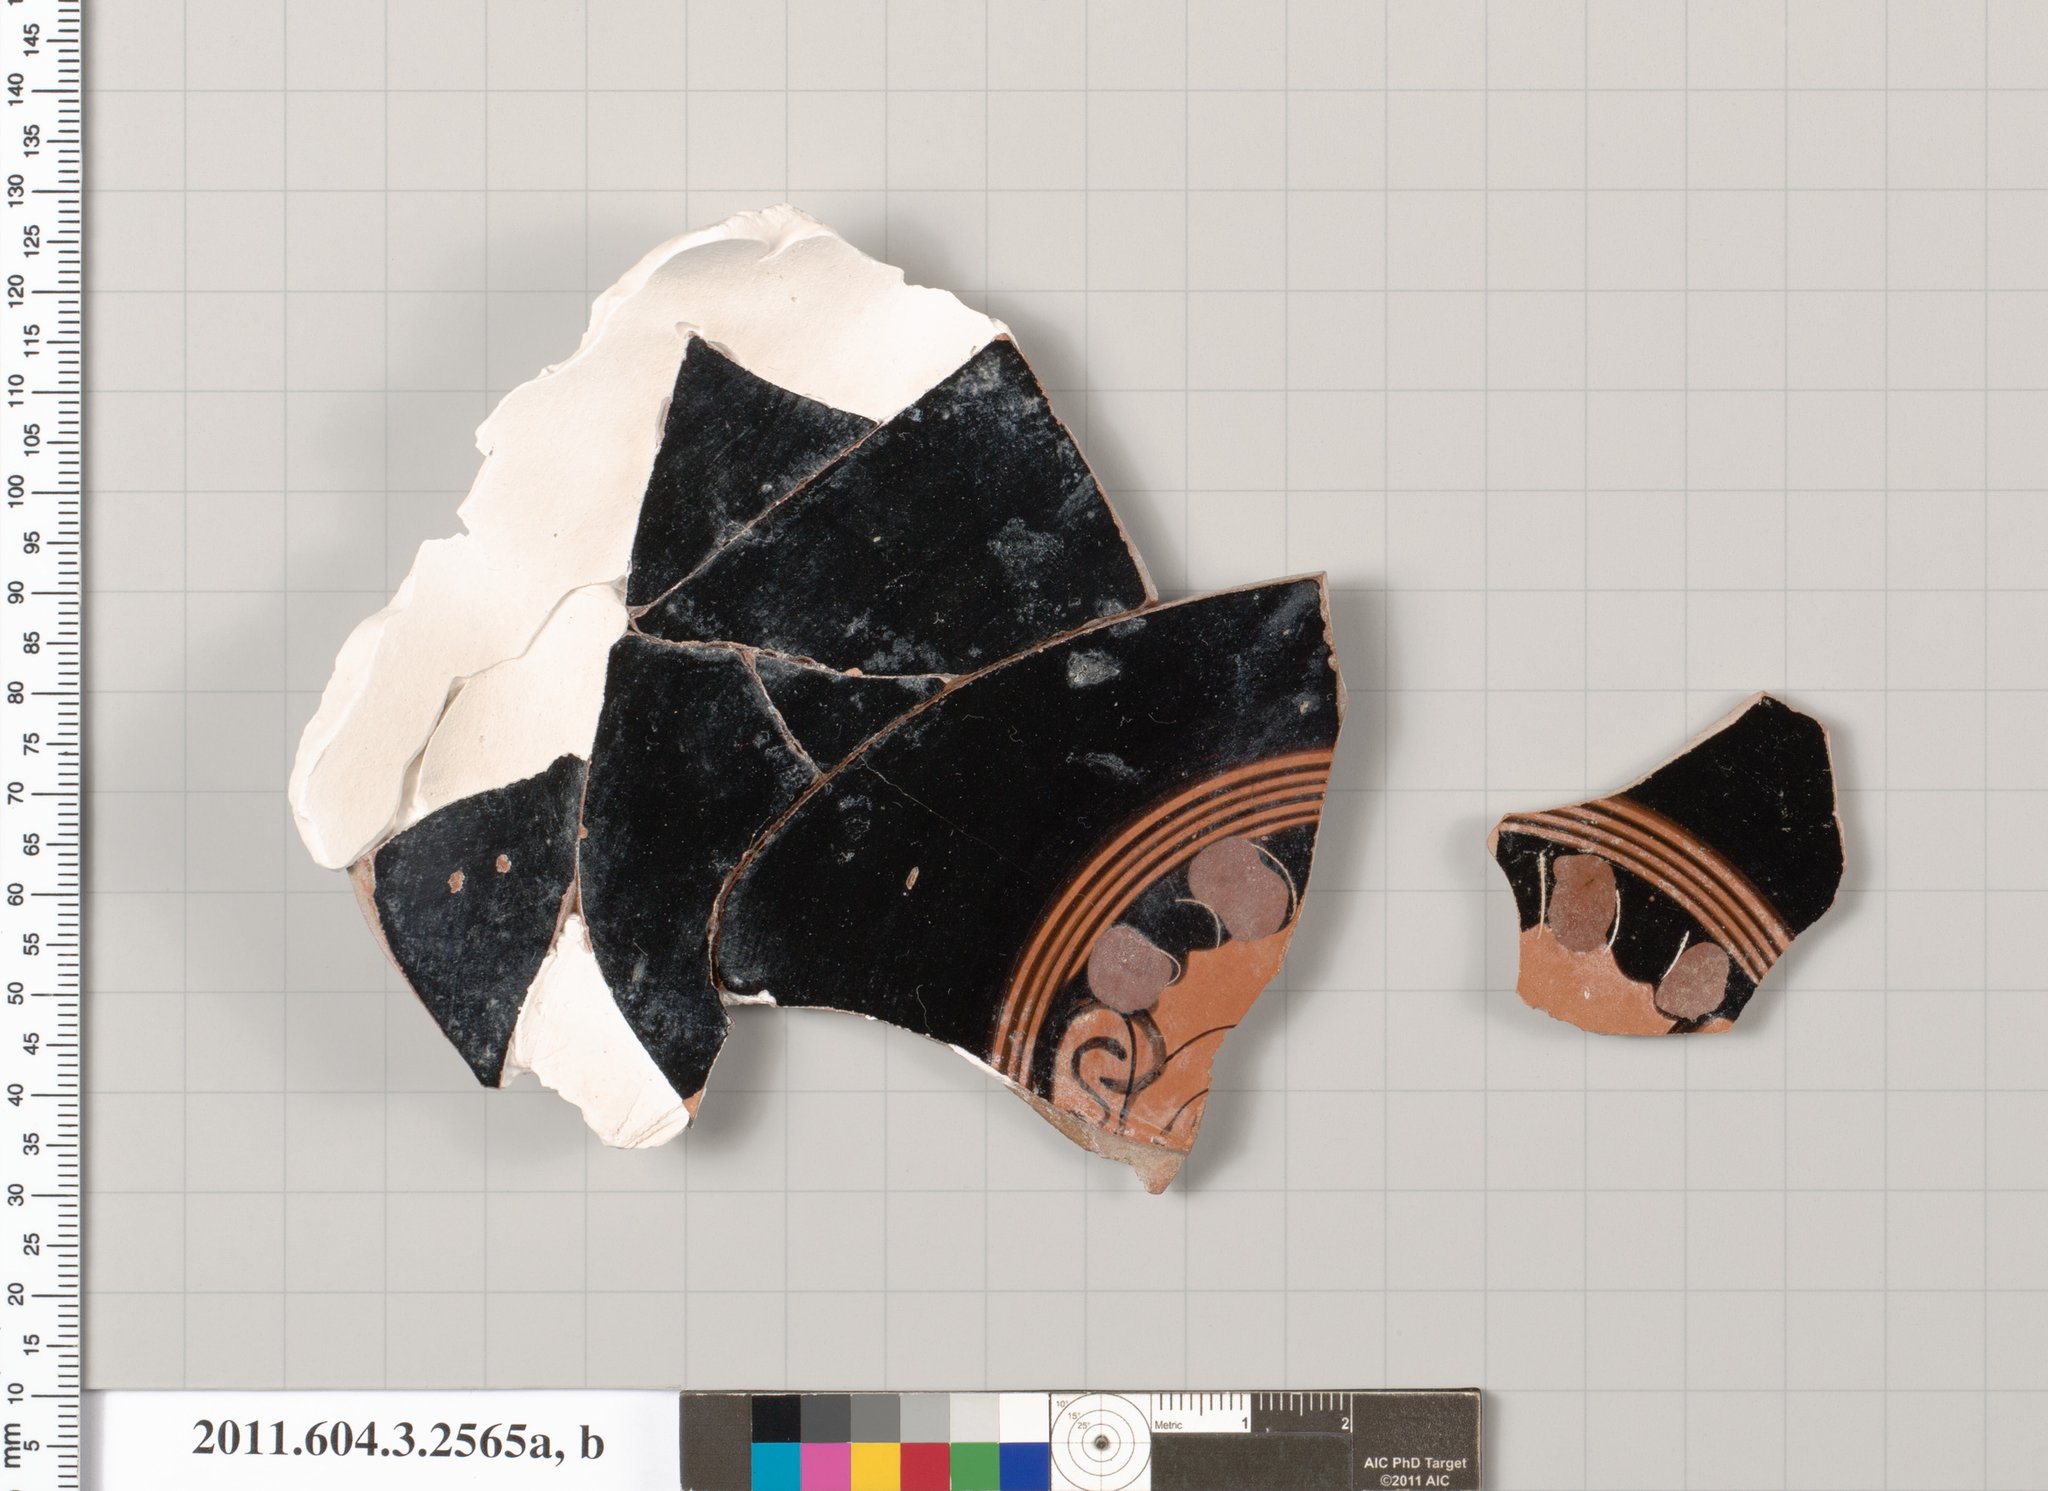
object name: kylix fragment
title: Terracotta fragments of a kylix: eye-cup (drinking cup)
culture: greek, attic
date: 530-520 BCE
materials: terracotta